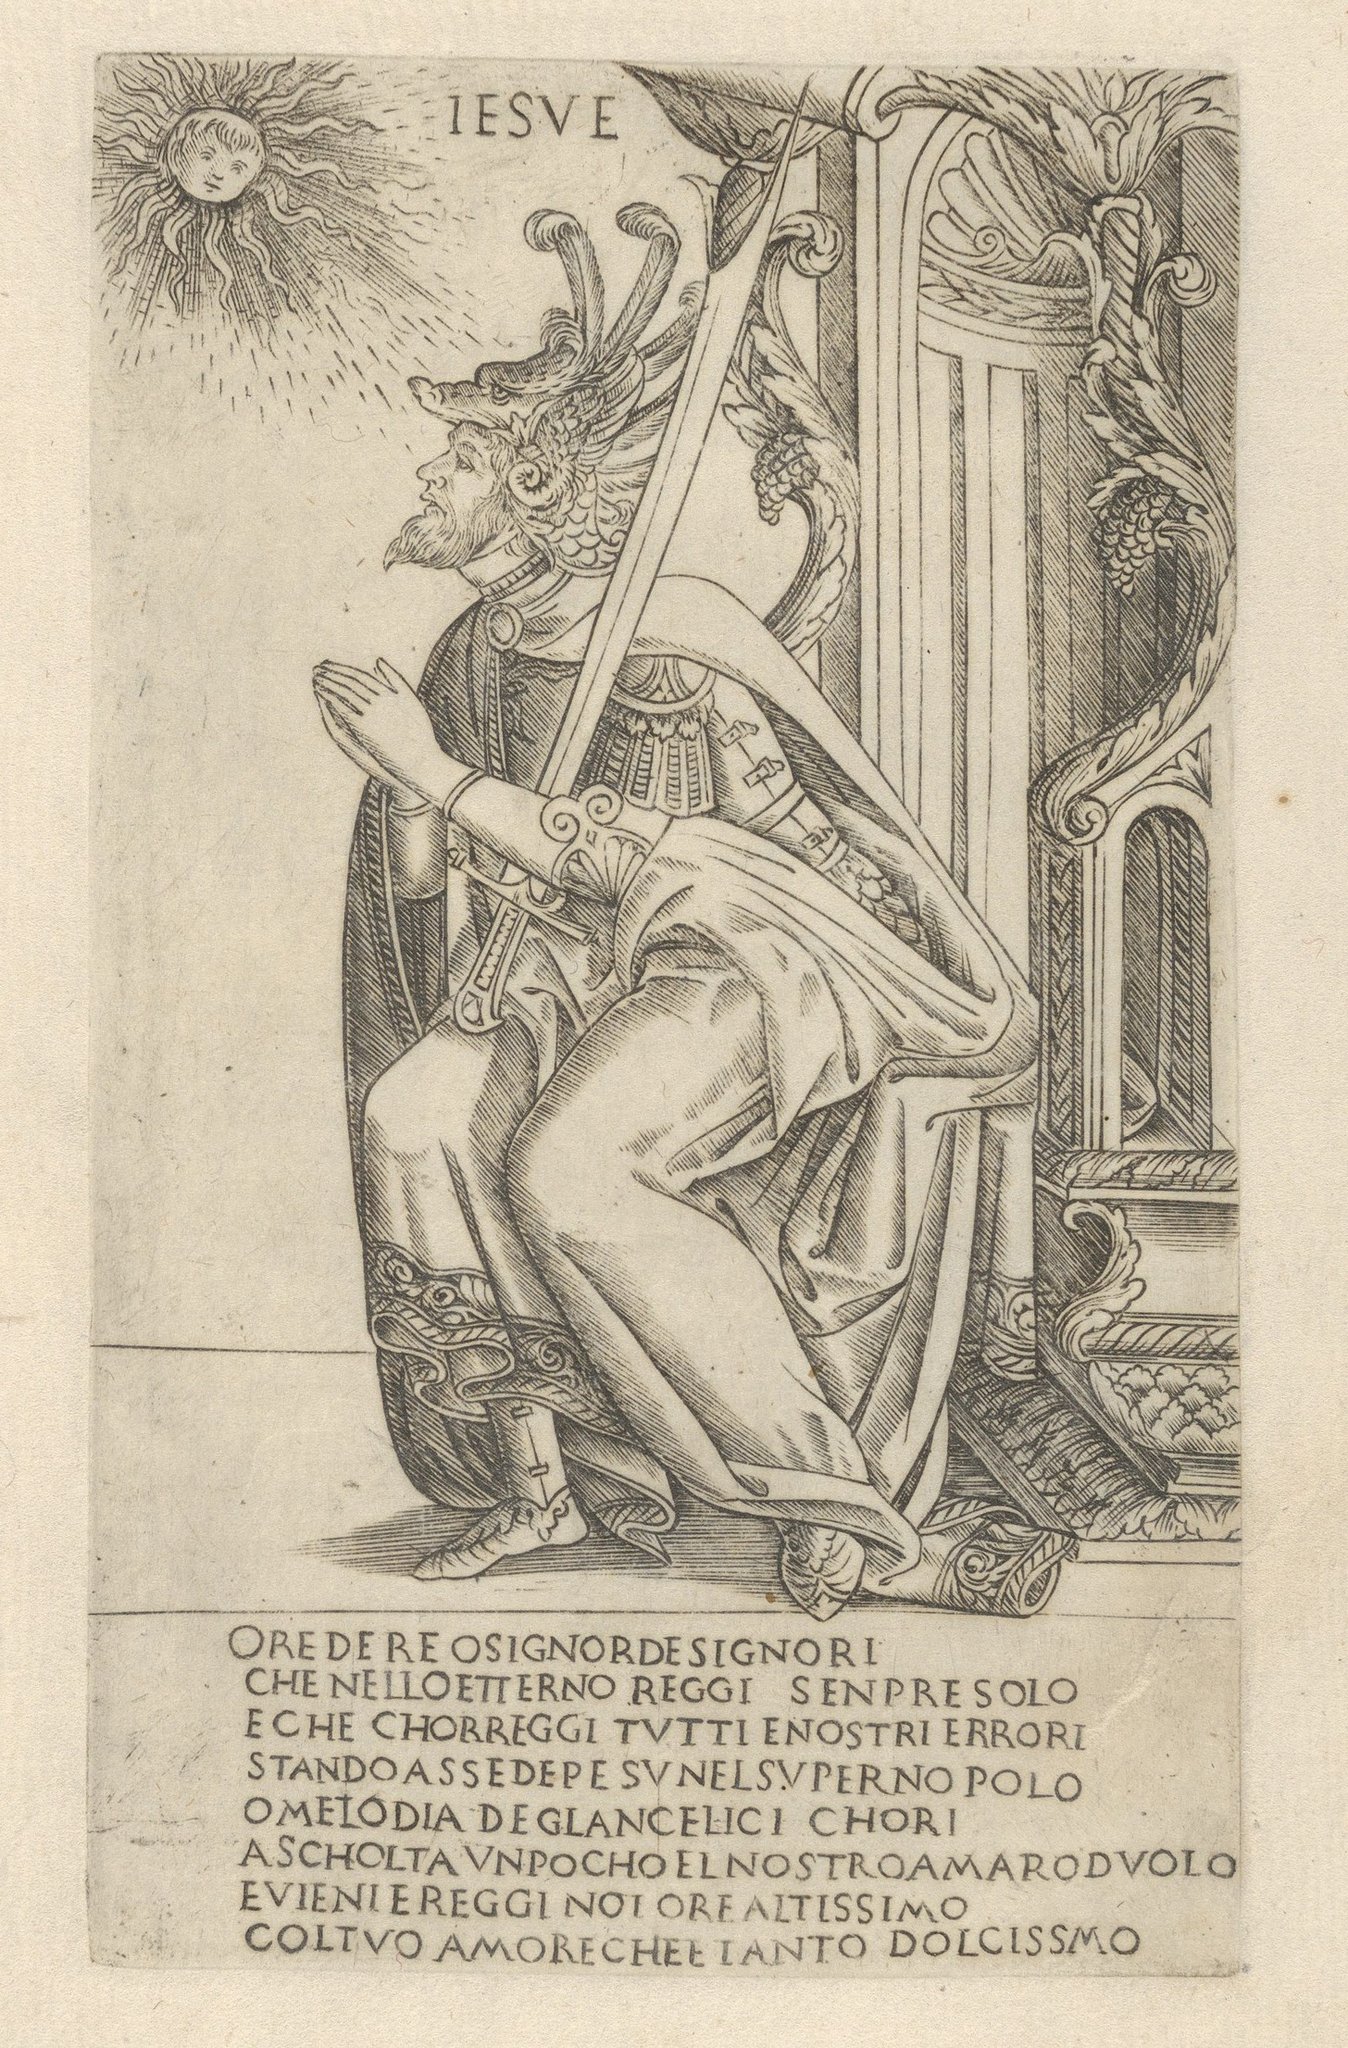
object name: print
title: The Prophet Joshua, from Prophets and Sibyls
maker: francesco rosselli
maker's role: artist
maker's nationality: italian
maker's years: 1448-1527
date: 1480-1490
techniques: engraving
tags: joshua